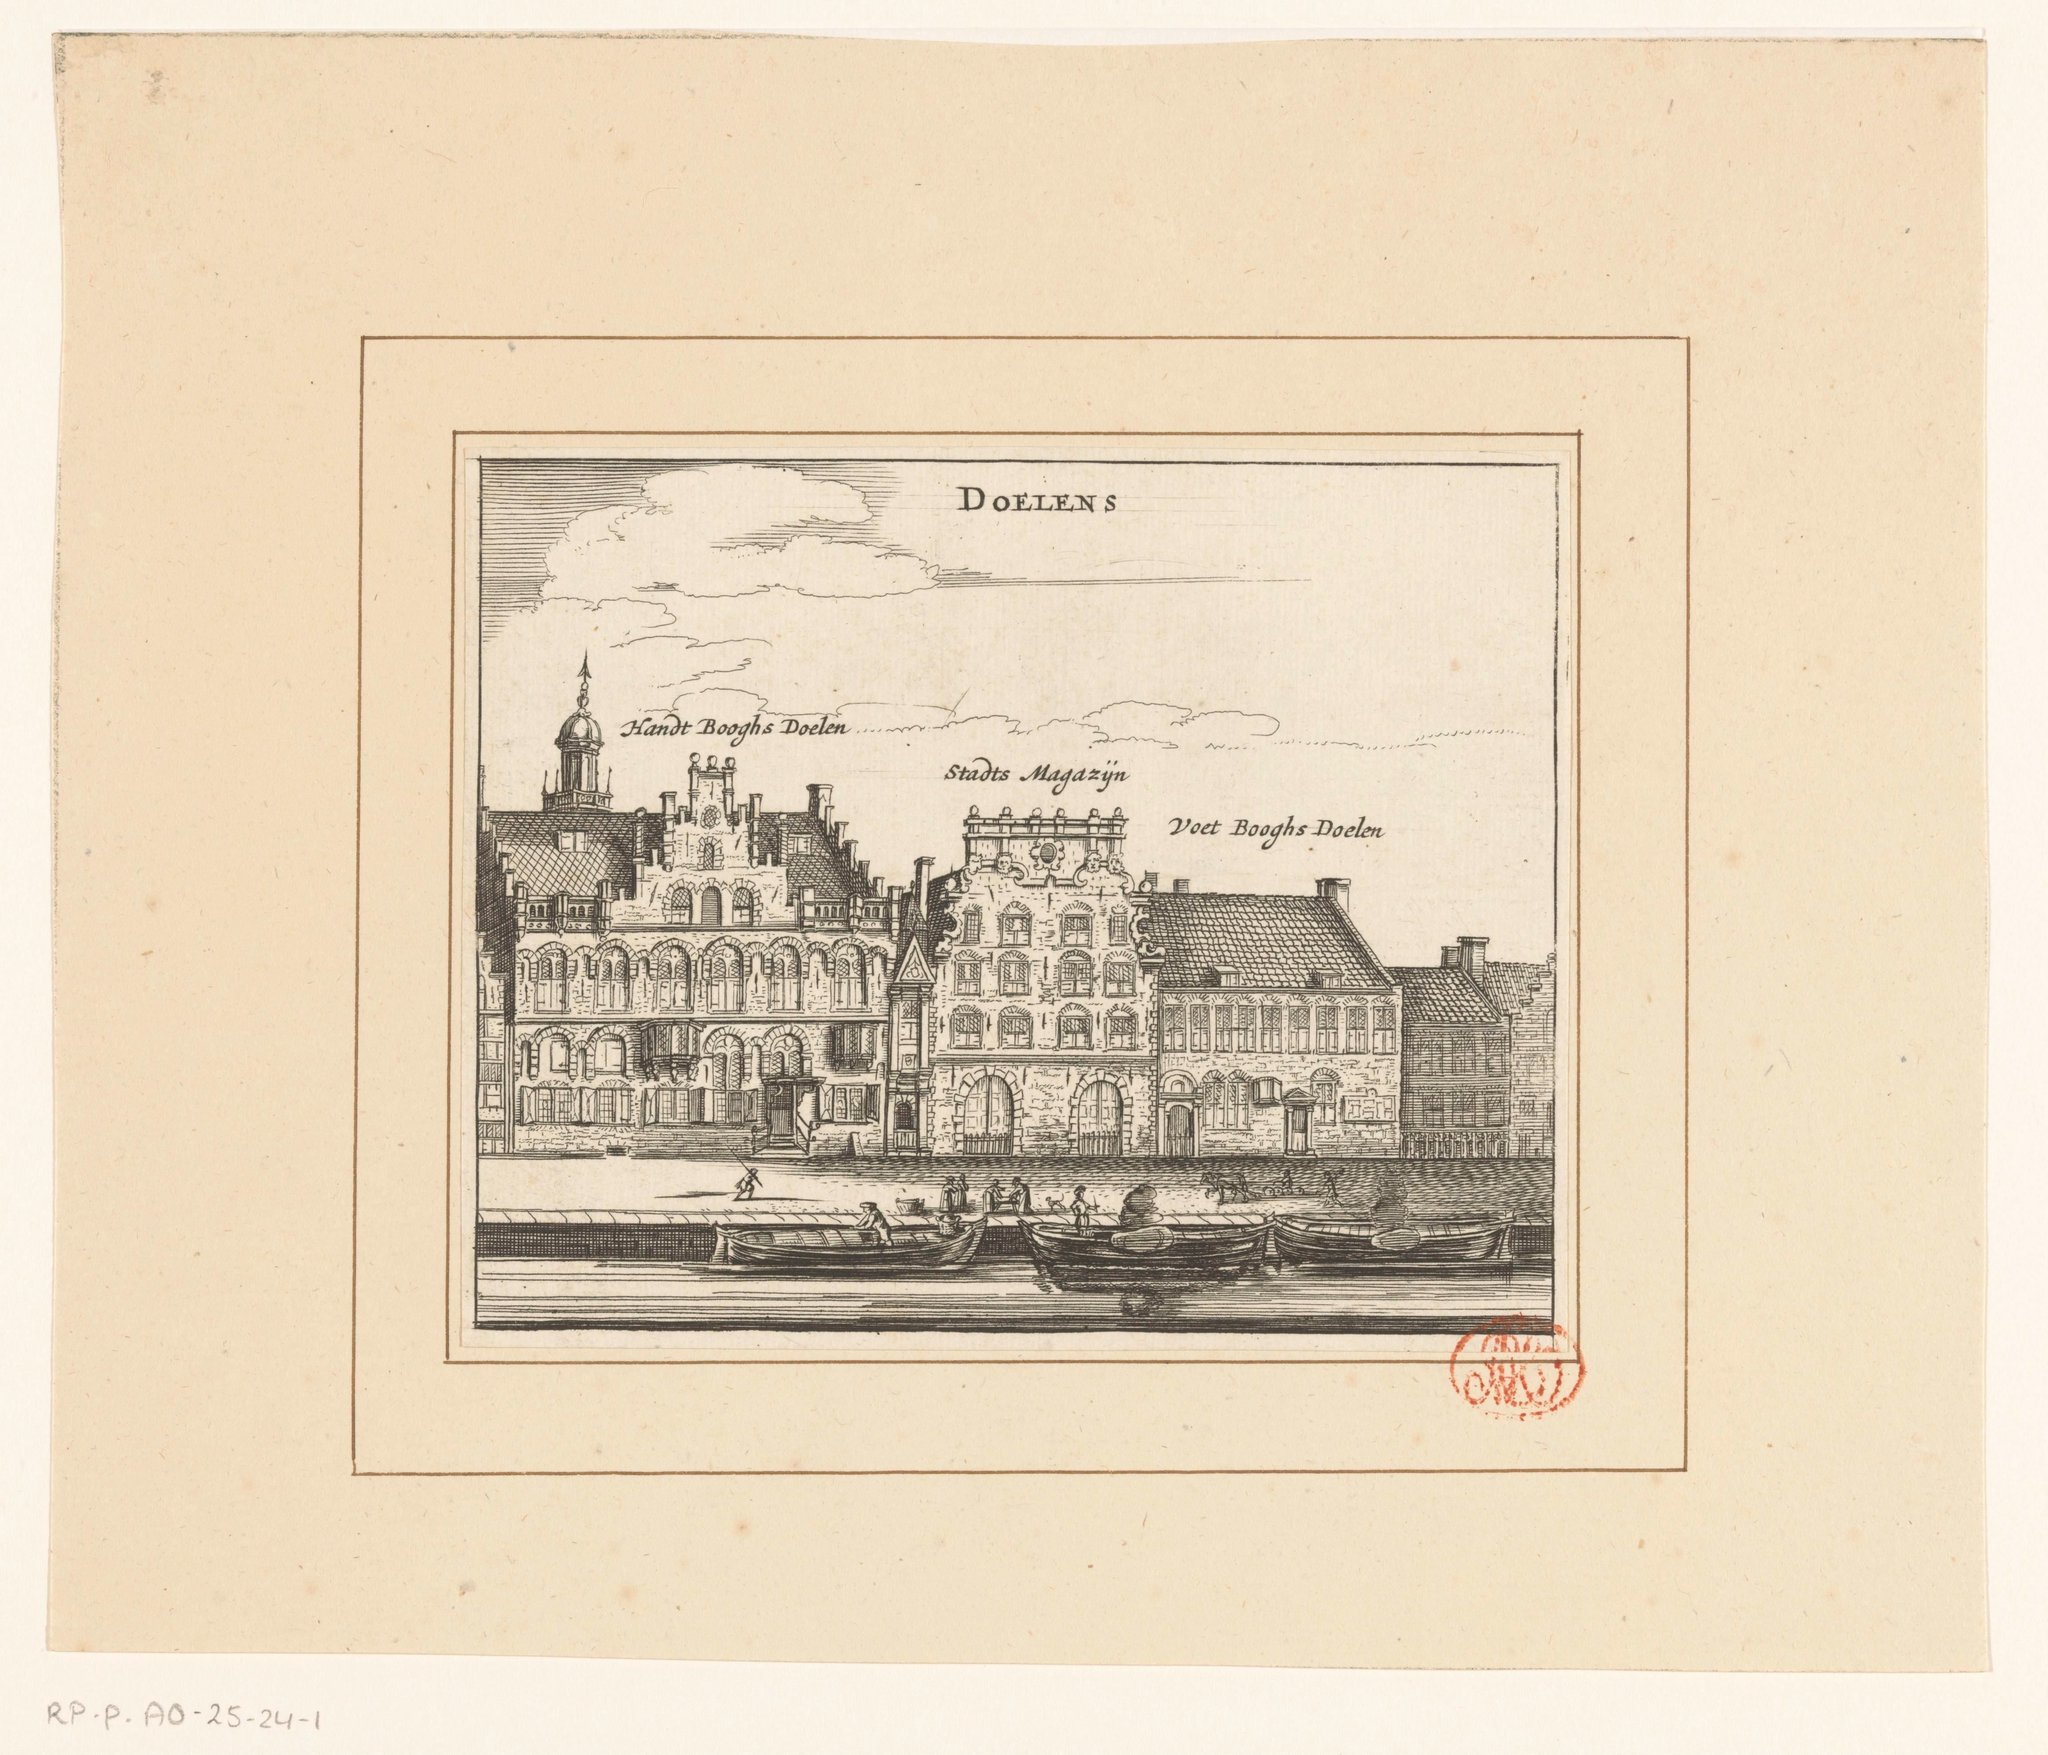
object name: print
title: Doelens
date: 1664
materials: paper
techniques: engraving, etching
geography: amsterdam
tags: land forces (+ citizen soldiery, civil guard, citizen militia), ammunition store, arsenal, street (+ city(-scape) with figures, staffage)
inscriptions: collector's mark: Lugt 195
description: Huidige staat van prent ook gebruikt in: Fockens, Melchior. Beschrijving Der wijdt-vermaarde Koop-stadt Amstelredam, Van haar eerste beginselen, zedert den Jare 1203. oude Voorrechten, verscheyde Vergrootingenoude Voor-rechten, en verscheyde Vergrootingen (…). 3e druk. Amsterdam: Marcus Willemsz. Doornick, 1664. En in: Zesen, Philipp von. Beschrybung der Weidtberuhmde Kauf-Stadt Amstelredam / Beschreibung der Stadt Amsterdam darinnen von derselben ersten ursprunge bis auf gegenwartigen zustand (…). Amsterdam: Marcus Willemsz. Doornick, 1664. Tweede bekende staat (met toevoeging Franse titel) ook gebruikt in: Domselaer, Tobias en Isaac Commelin. Beschryvinge van Amsterdam : haar eerste oorspronk uyt den huyze der heeren van Aemstel en Aemstellant (…). 6 delen. Amsterdam: Marcus Willemsz van Doornick, 1665. Derde bekende staat (rechtsboven genummerd: 48) ook gebruikt in verschillende latere zeventiende- en achttiende-eeuwse publicaties.